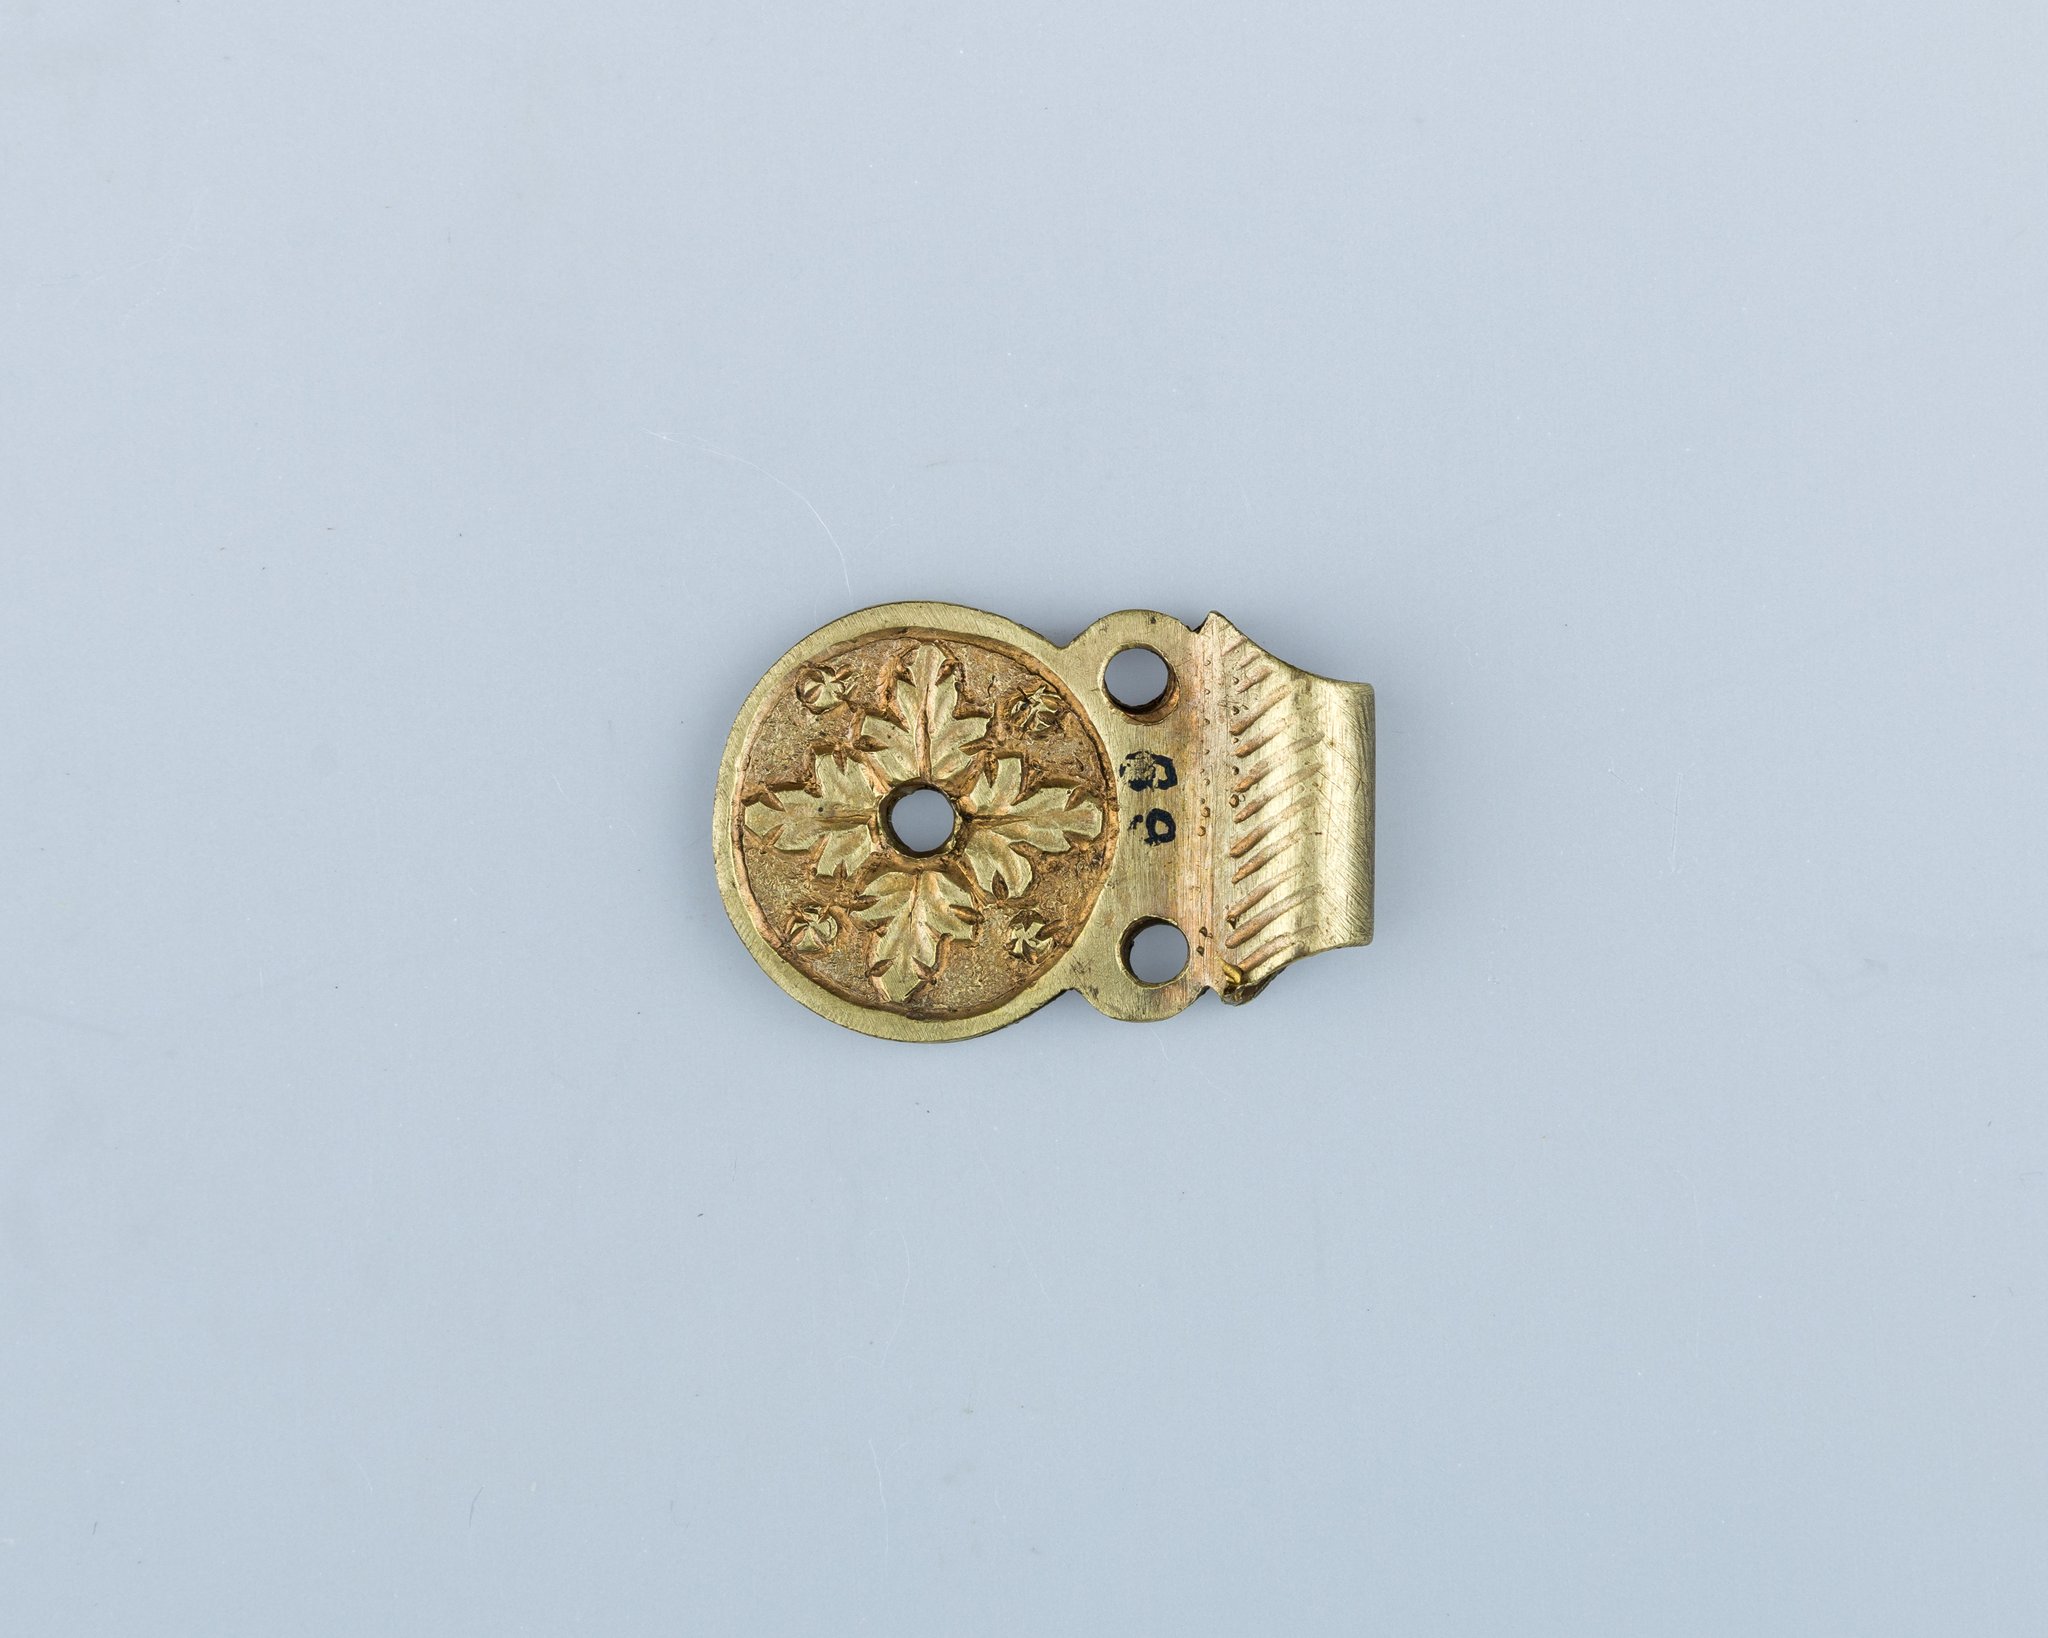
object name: mordant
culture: german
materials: brass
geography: germany